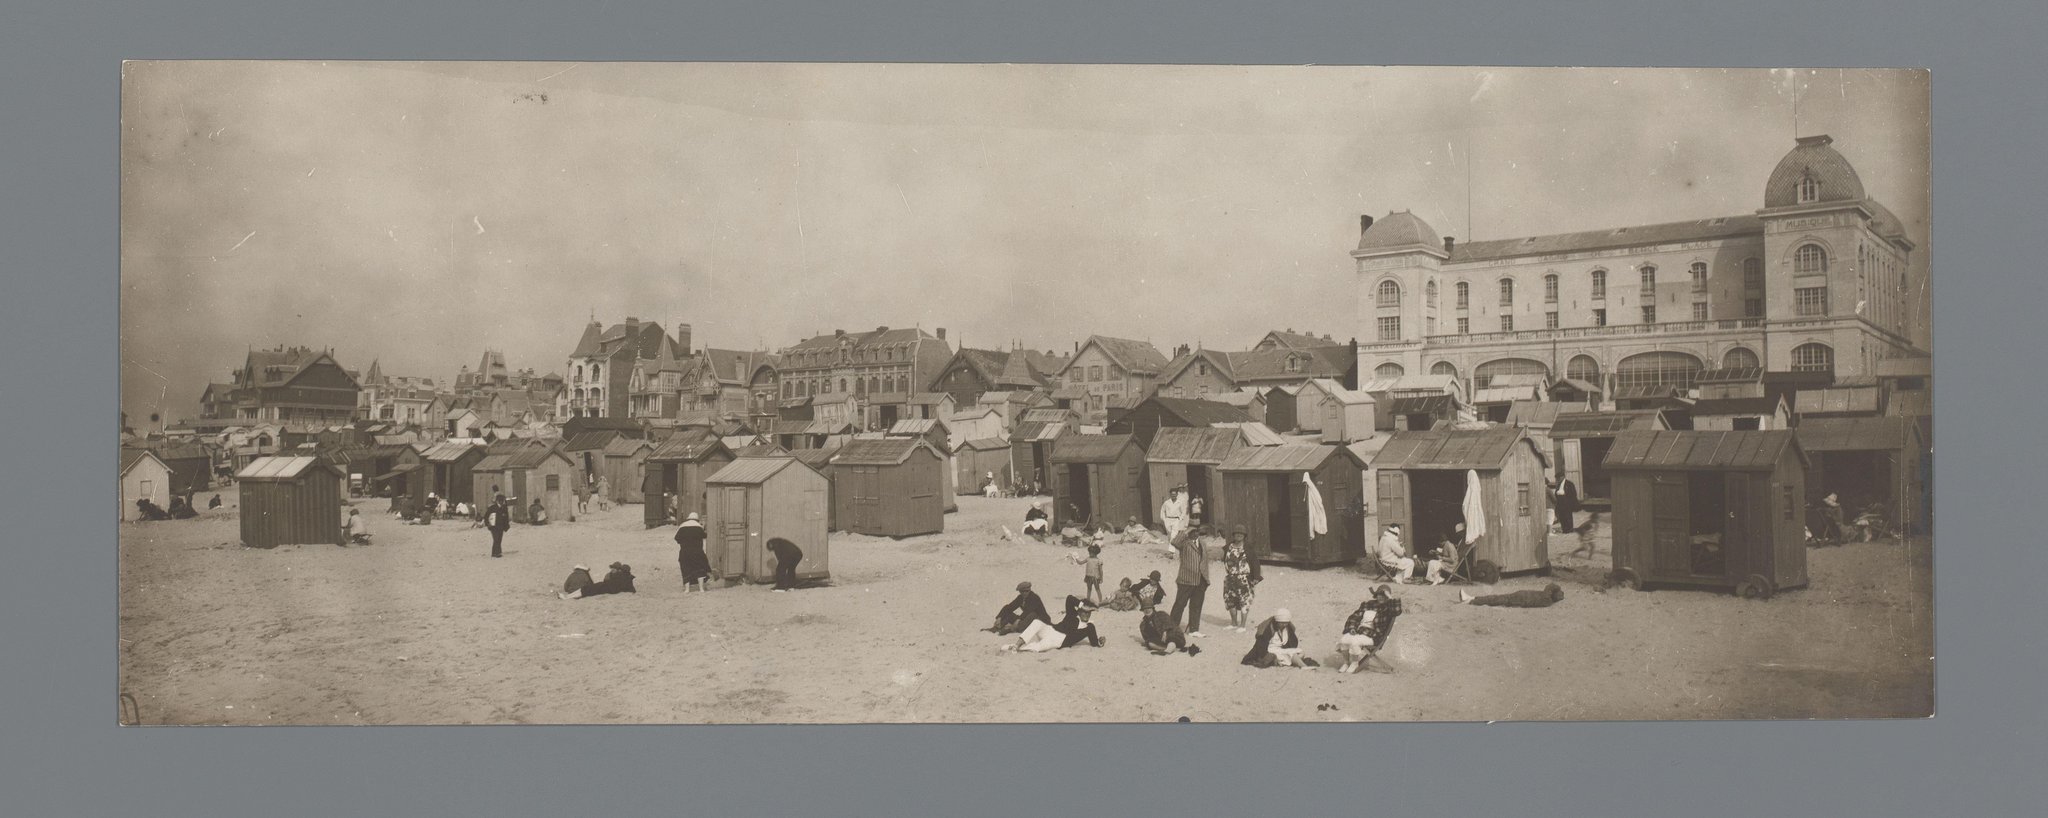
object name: panoramic photograph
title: Strand aan de Noordzeekust, België of Frankrijk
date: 1920-1940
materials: photographic support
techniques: gelatin silver print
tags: beach (as place of recreation), france, belgium